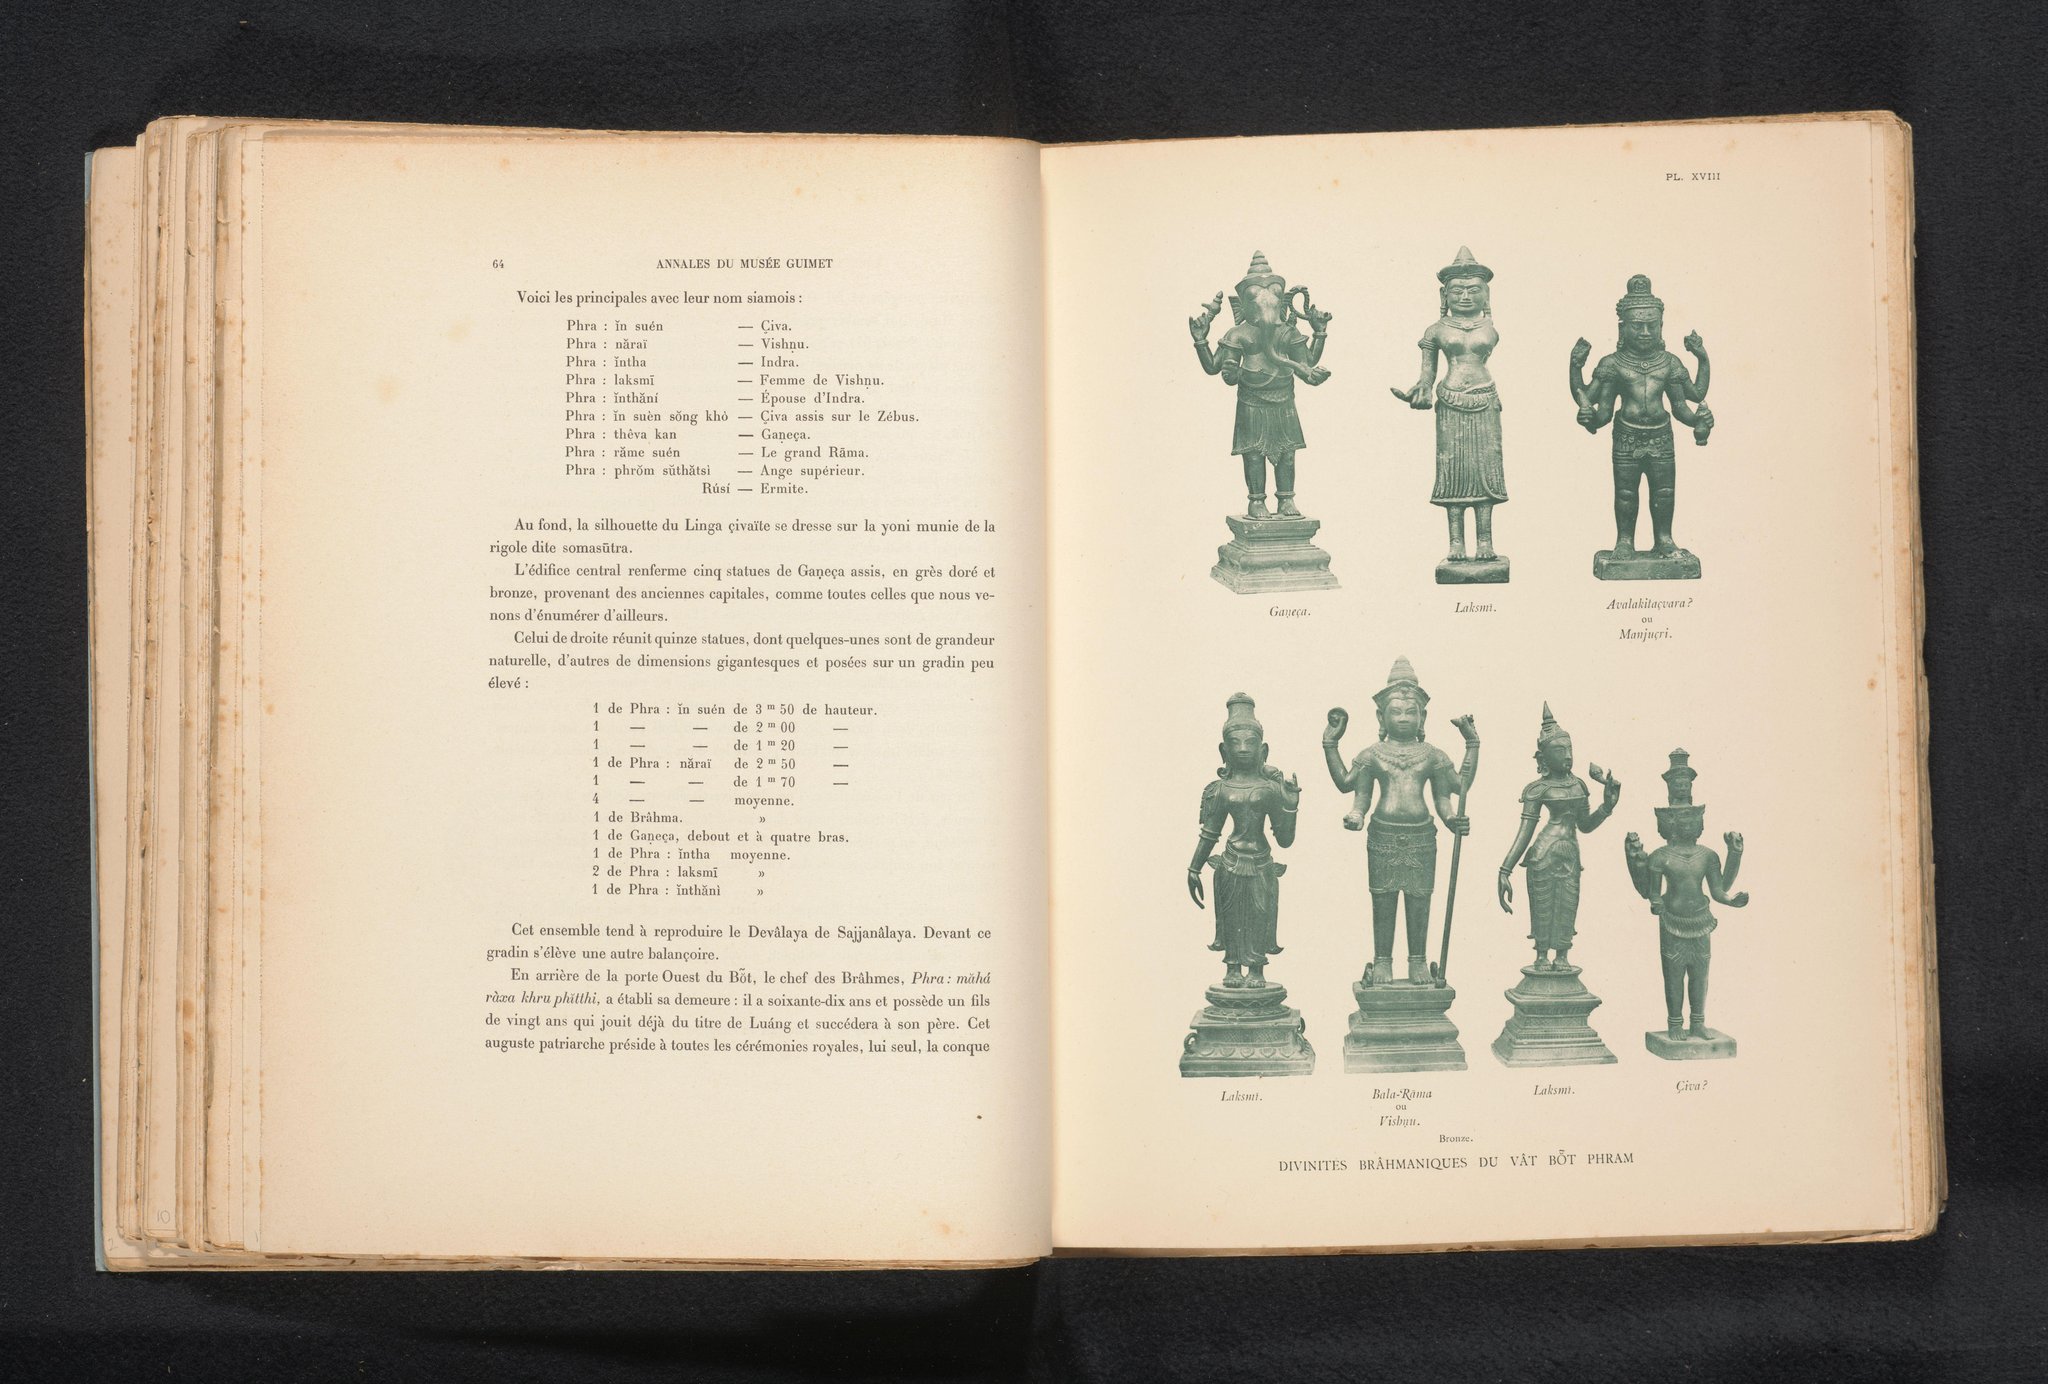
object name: page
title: Zeven sculpturen van Brahmanische goden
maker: Anonymous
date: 1890-1895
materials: paper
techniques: photograph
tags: hinduism, buddhism, jainism, sculpture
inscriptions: inscription: ‘Ganeça, Laksm, Avalakitaçvara? ou Manjuçri/ Laksmi, Bala-Rāma ou Vishnu, Laksmi, Civa’, collector's mark: ‘Société d'Emulation de l'Ain/ Bourg/ Bibliothèque’, inscription: ‘Pl. XVIII’